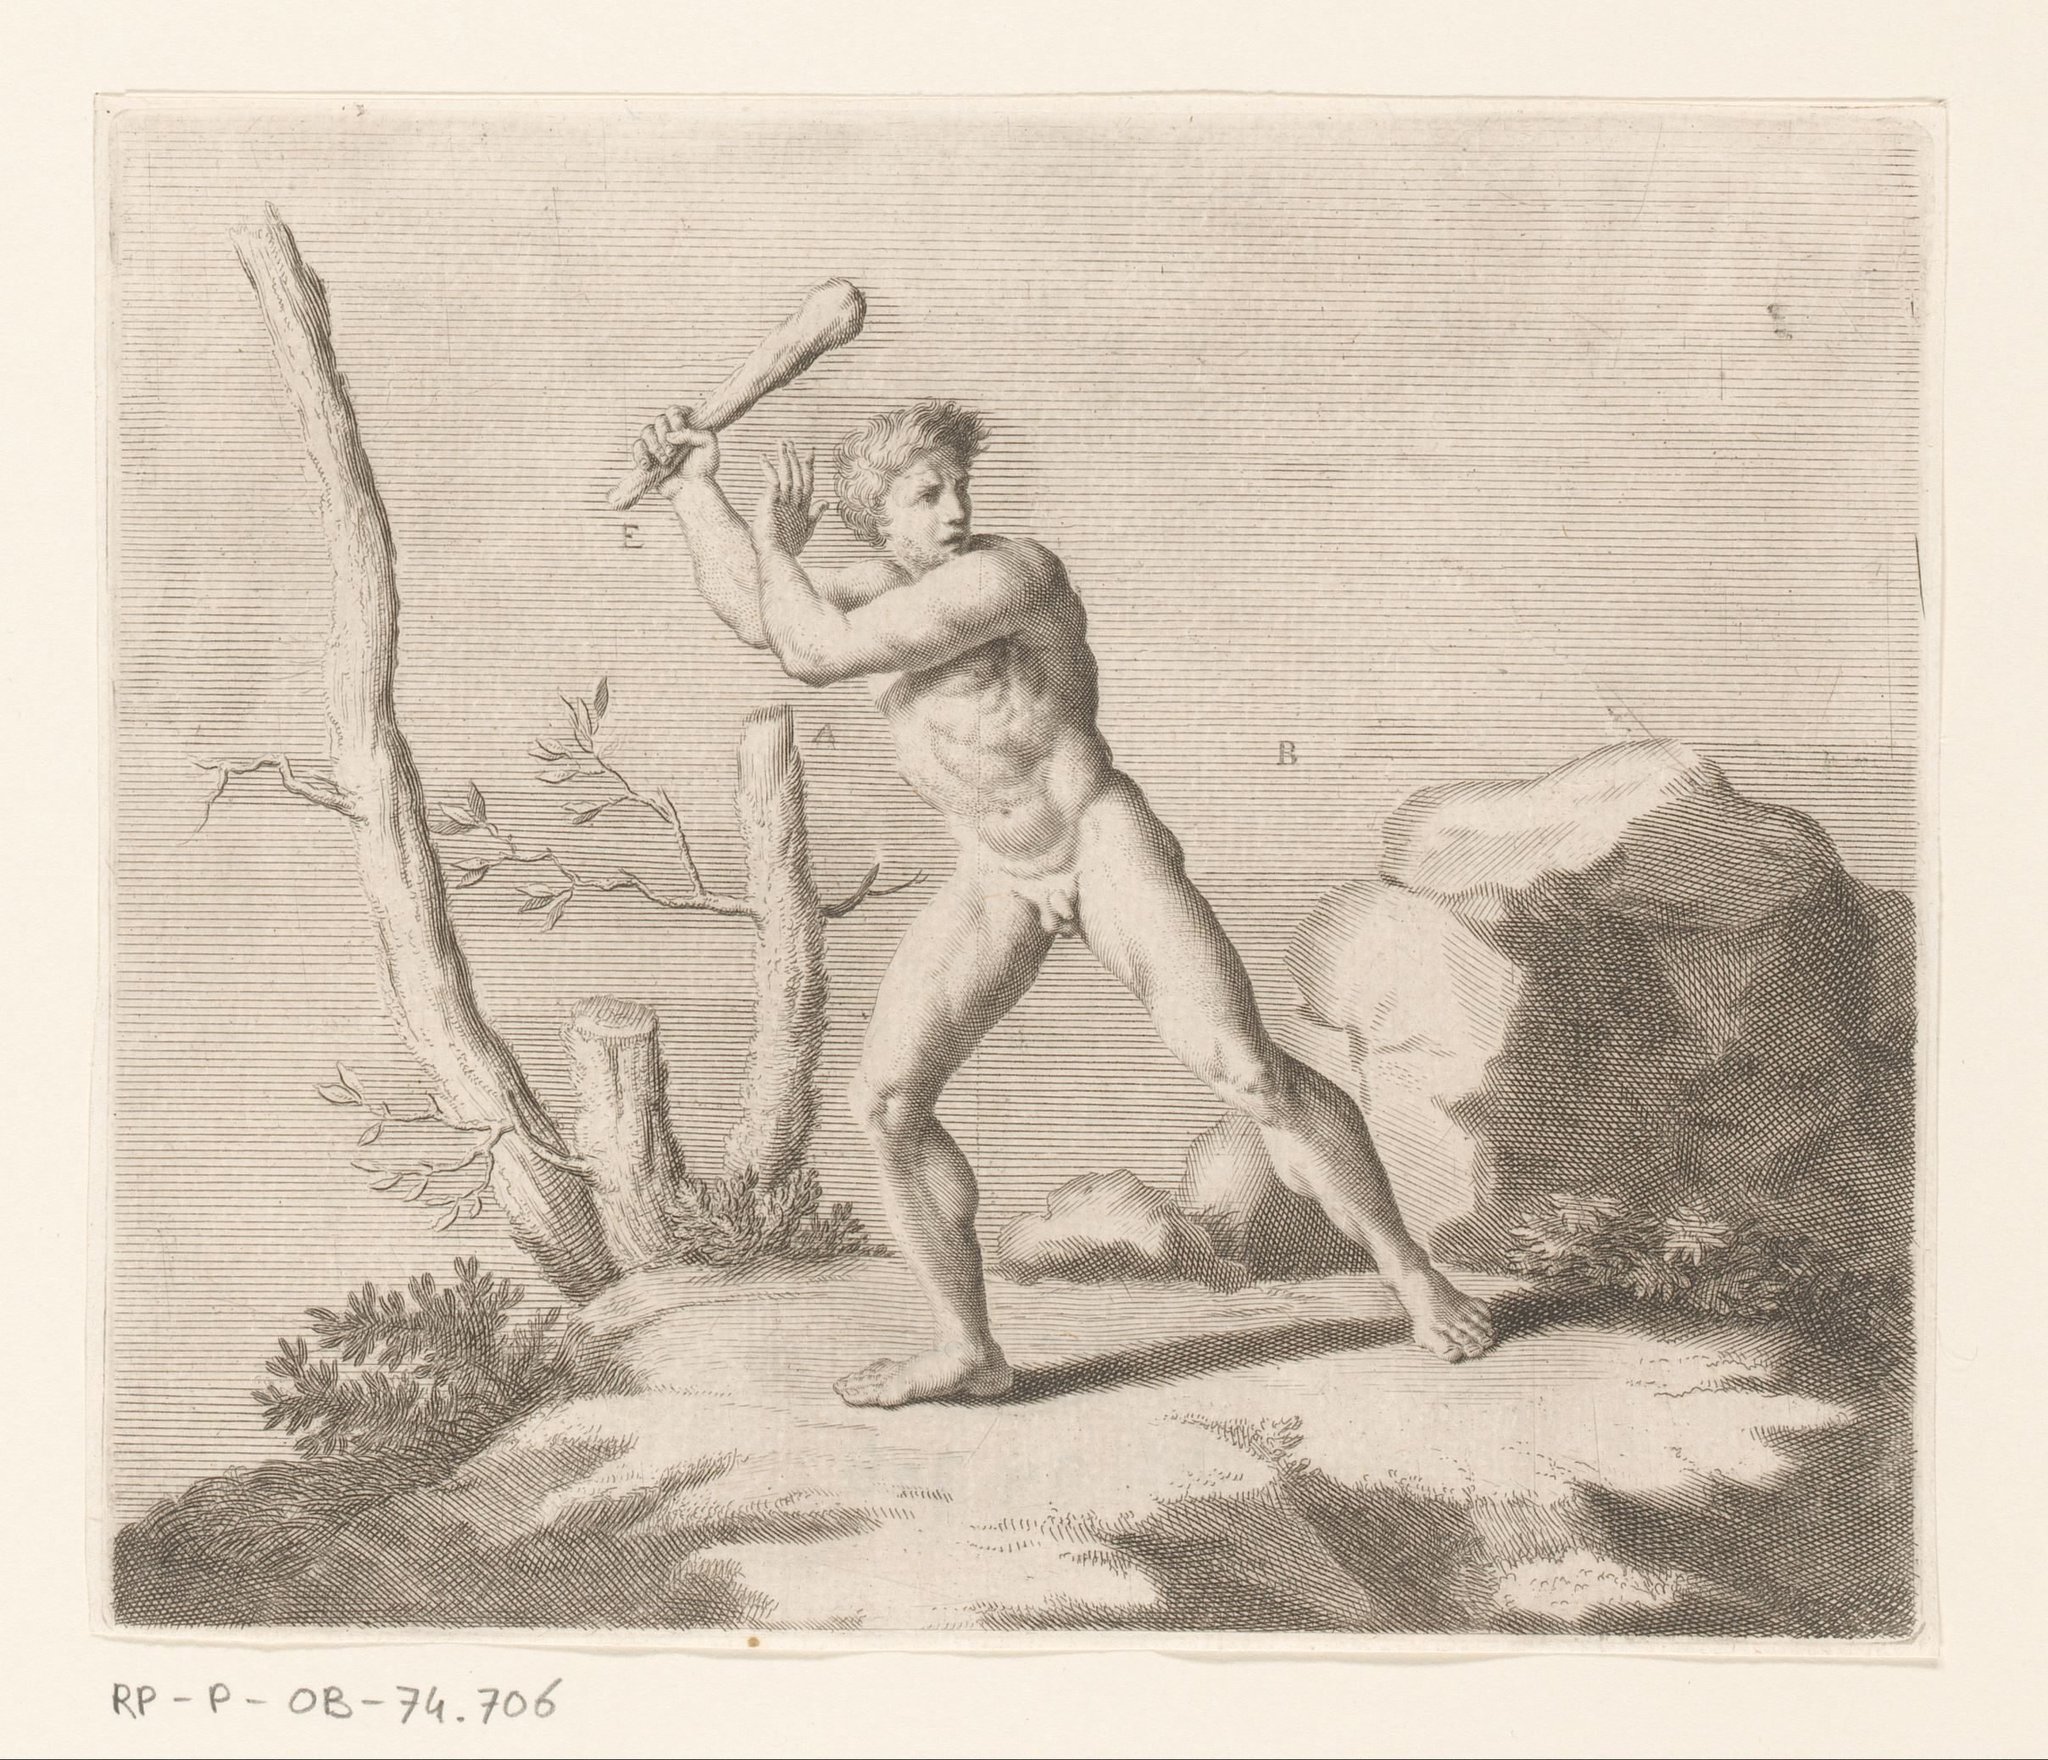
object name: print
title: Naakte man met opgeheven knots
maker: Anonymous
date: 1600-1699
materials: paper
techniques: engraving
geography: france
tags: weapons for striking a blow: club, man (showing himself) undressed, quasi-nude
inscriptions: collector's mark: Lugt 2228